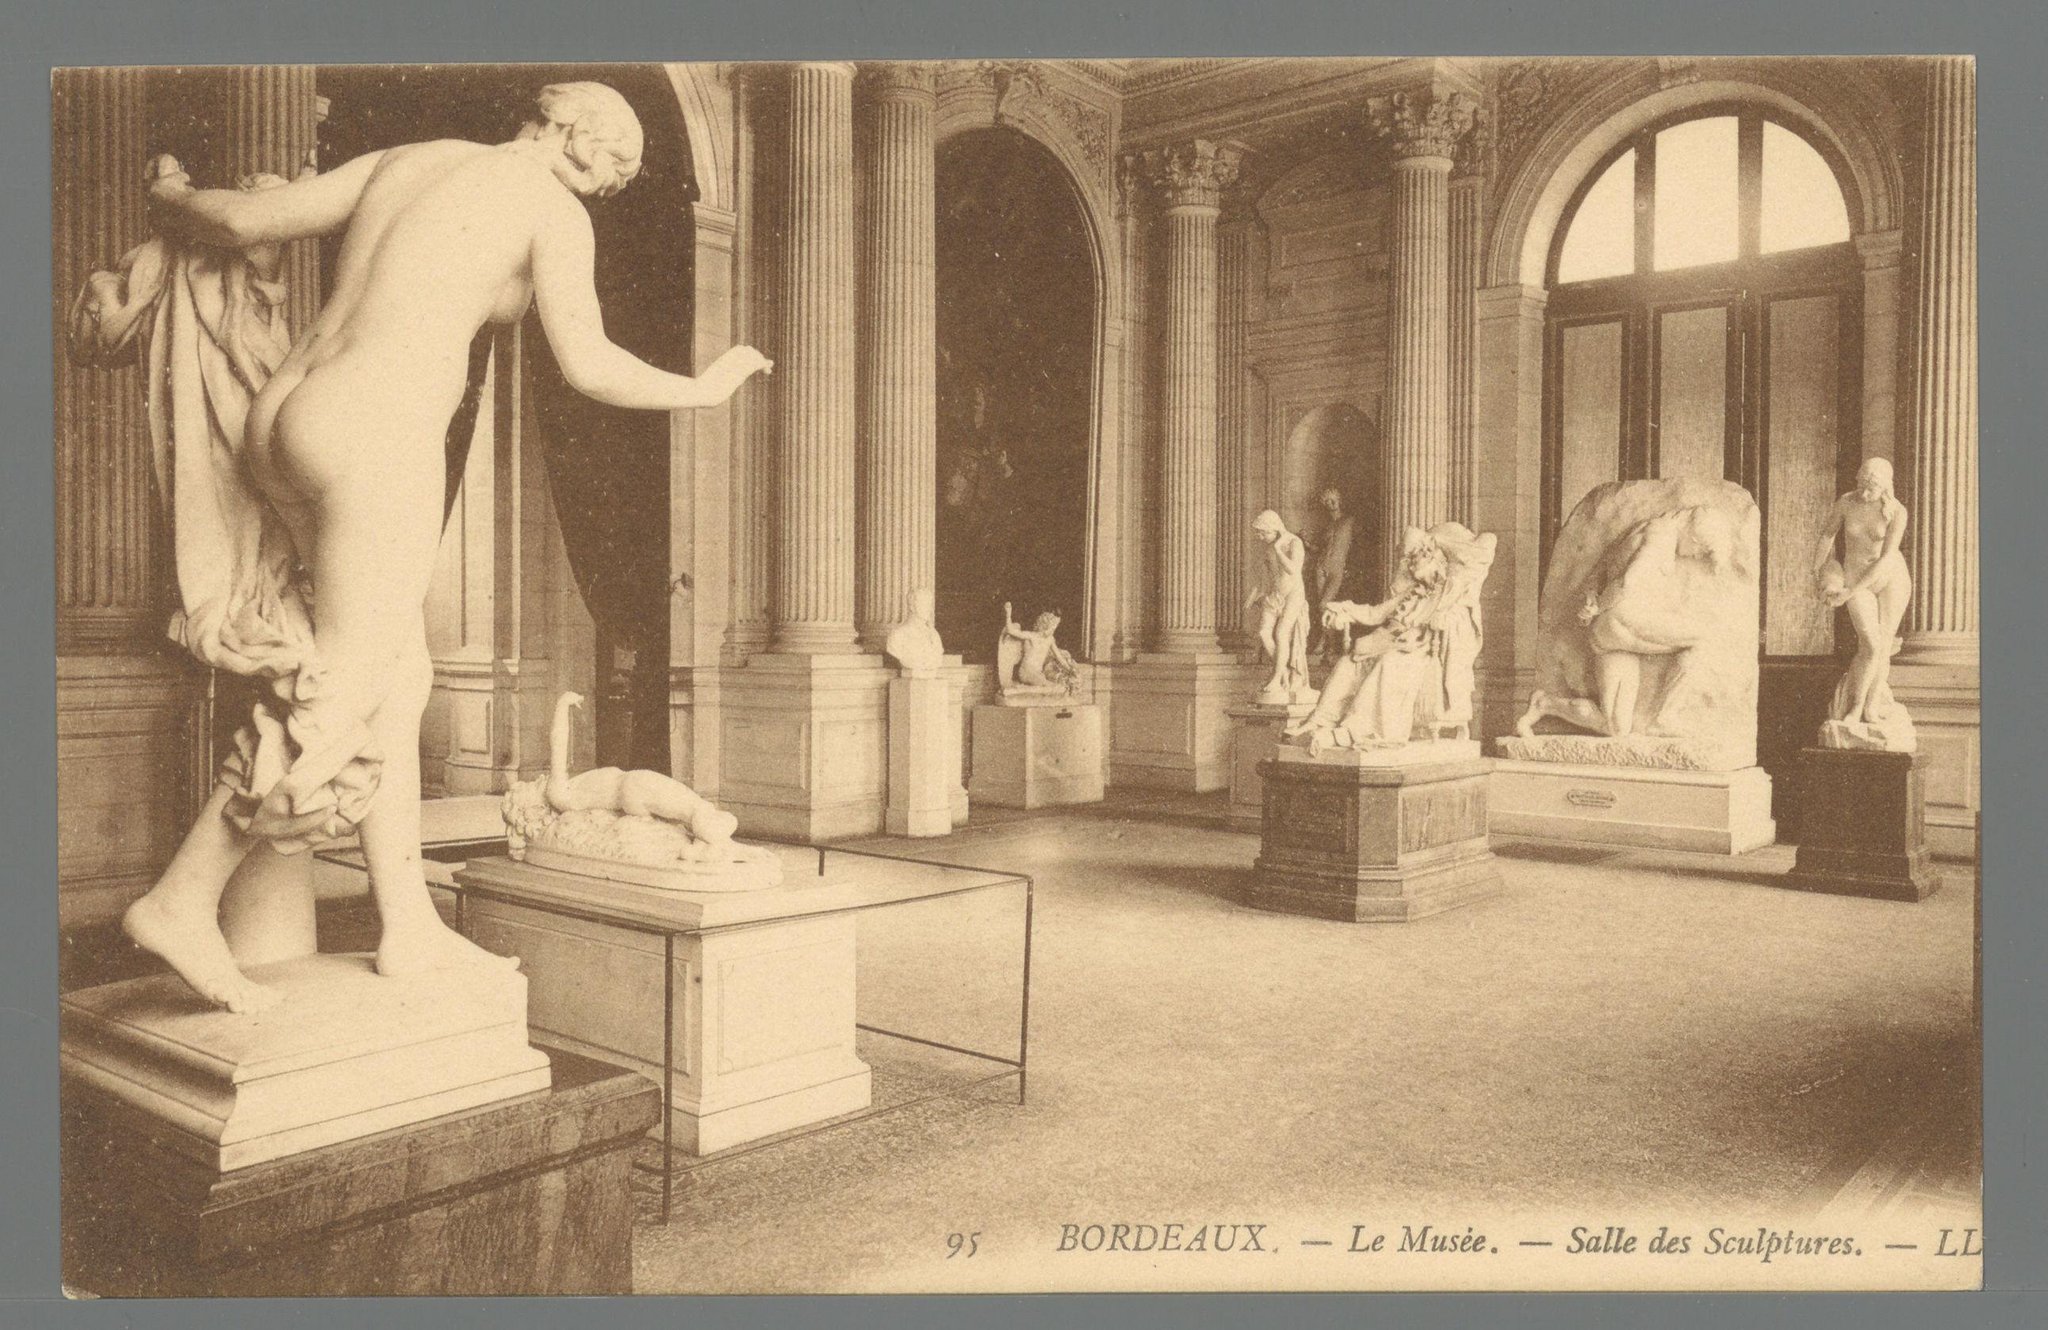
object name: photomechanical print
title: Bordeaux. Le Musée. Salle des Sculptures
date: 1903-1920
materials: cardboard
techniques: photograph, writing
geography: bordeaux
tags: permanent exhibition, museum, sculpture, interior ~ representation of a building